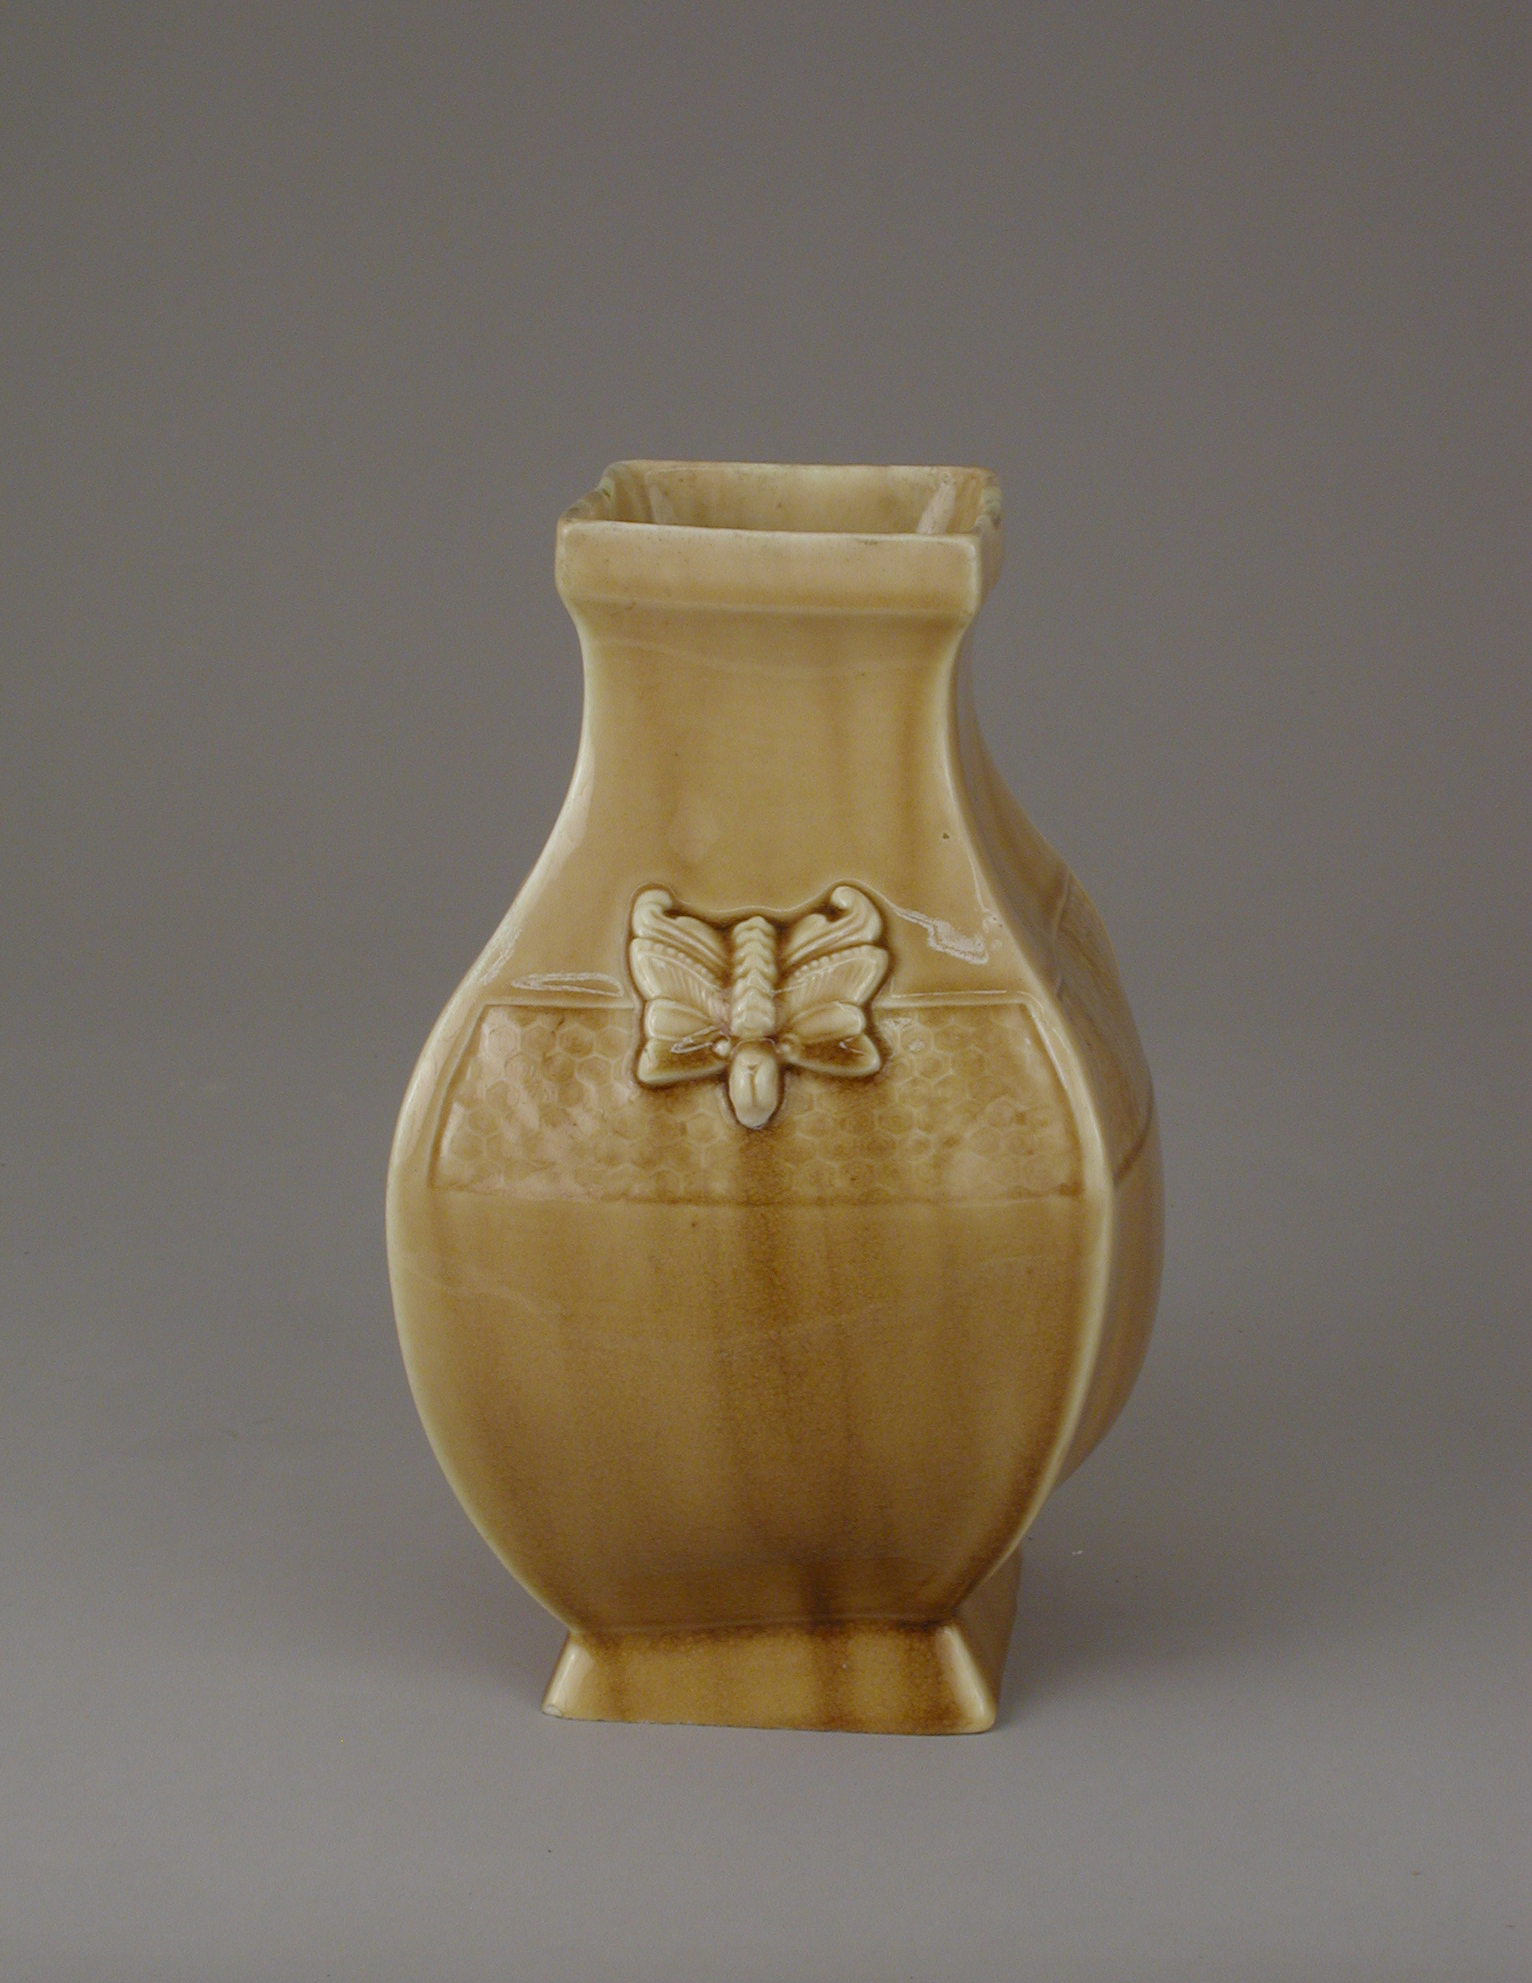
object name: vase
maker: haviland & co.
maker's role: factory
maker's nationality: american and french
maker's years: 1864-1931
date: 1880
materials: hard paste porcelain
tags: insects